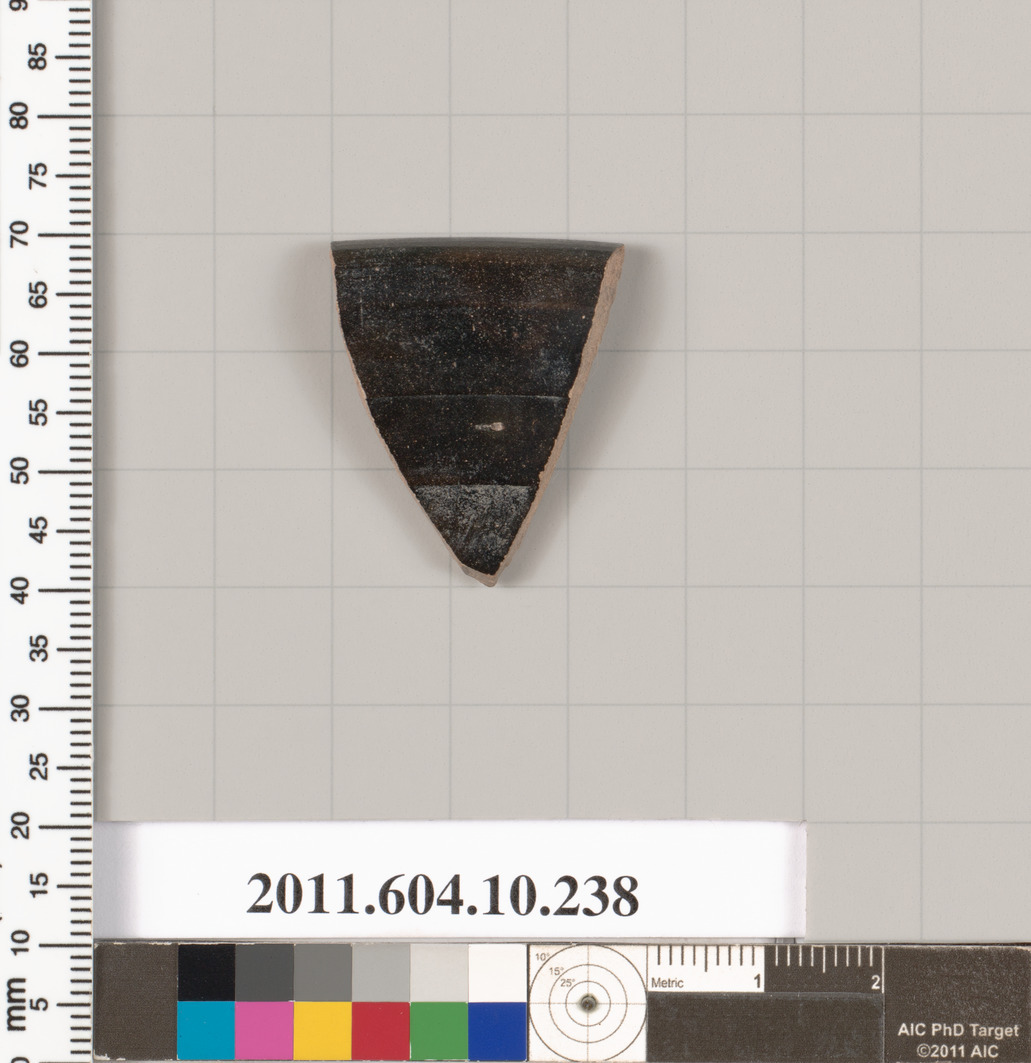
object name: underdetermined open shape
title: Terracotta rim fragment from an open shape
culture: etruscan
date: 601-700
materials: terracotta